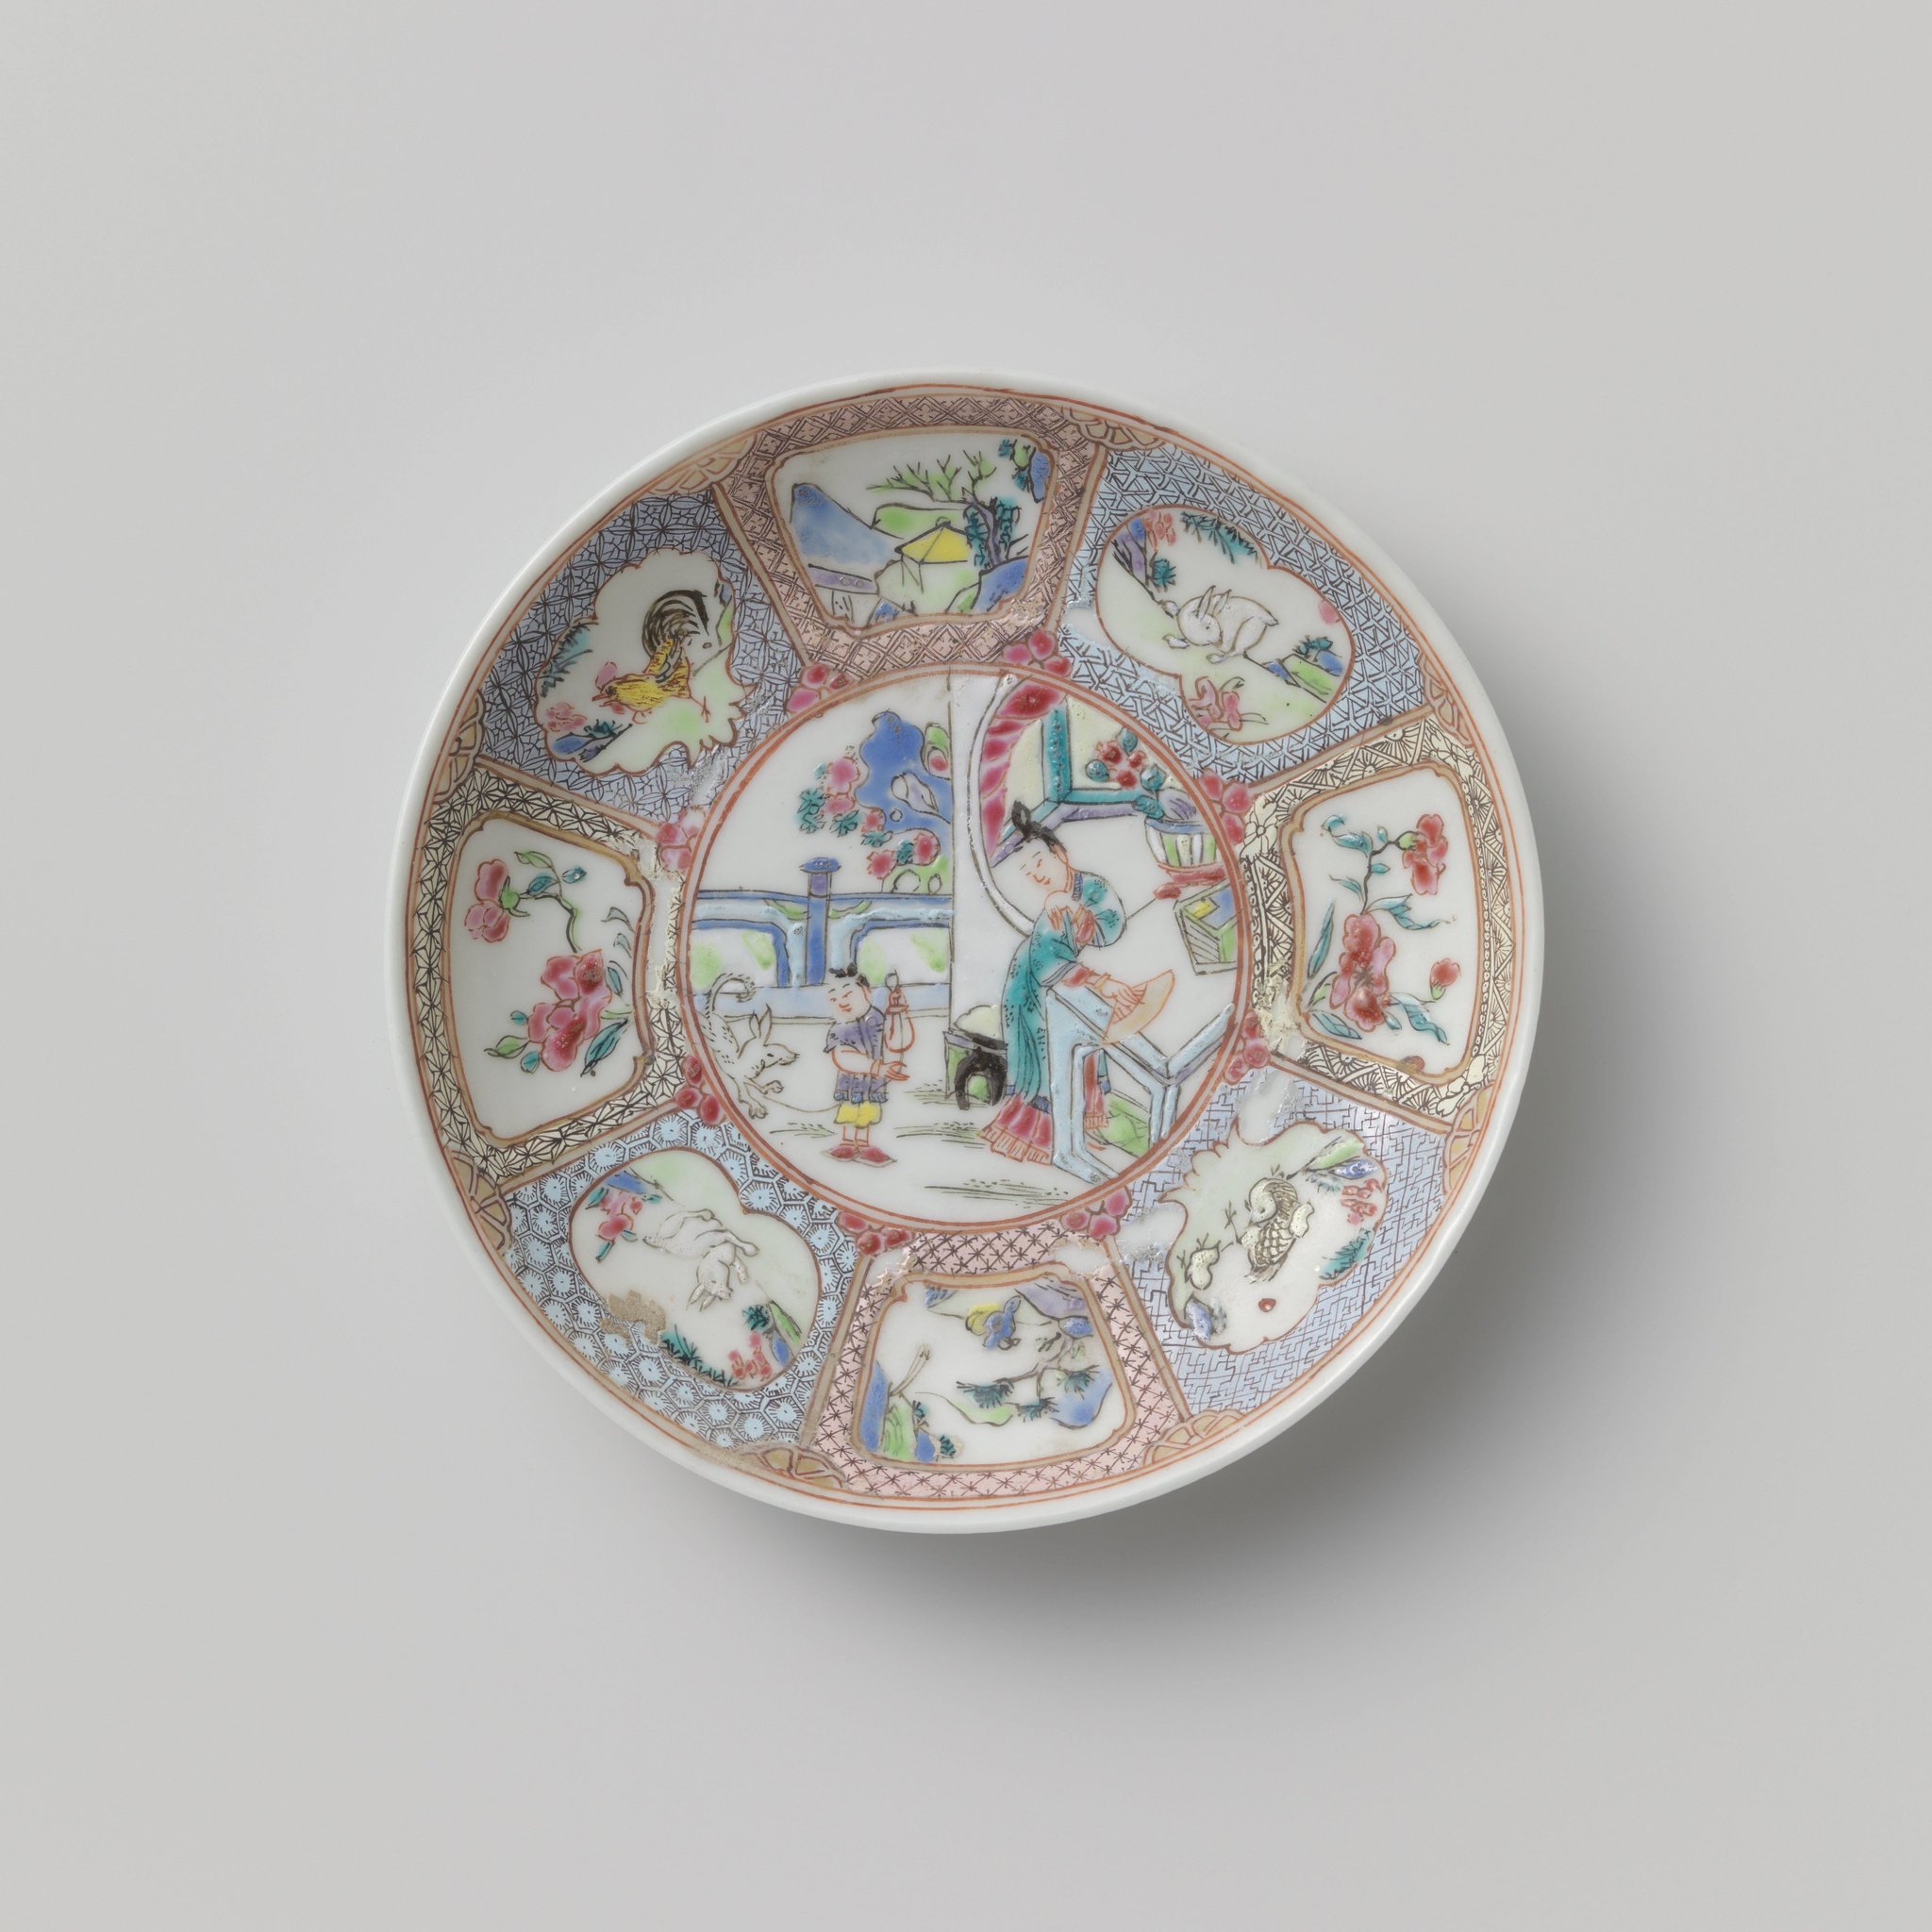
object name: platter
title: Saucer with woman and boy near a pavilion and panel decoration with landscapes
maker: Anonymous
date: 1725-1749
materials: glaze, gold, paint, porcelain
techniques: firing, gilding, turning, vitrification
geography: china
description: Schotel van porselein met ronde wand, beschilderd op het glazuur met blauw, rood, roze, groen, geel, zwart en goud. Op het plat een medaillon met een vrouw en kind op een terras voor een paviljoen; om het medaillon acht vakken met cartouches tegen verschillend gekleurde grond met servetwerk: twee vakken met granaatappelvormige cartouche met haan of vogel, vier waaiervormige cartouches met ingenepen hoeken met landschap en bloemtak, twee perzikvormige cartouches met haas in een landschap. Famille rose.